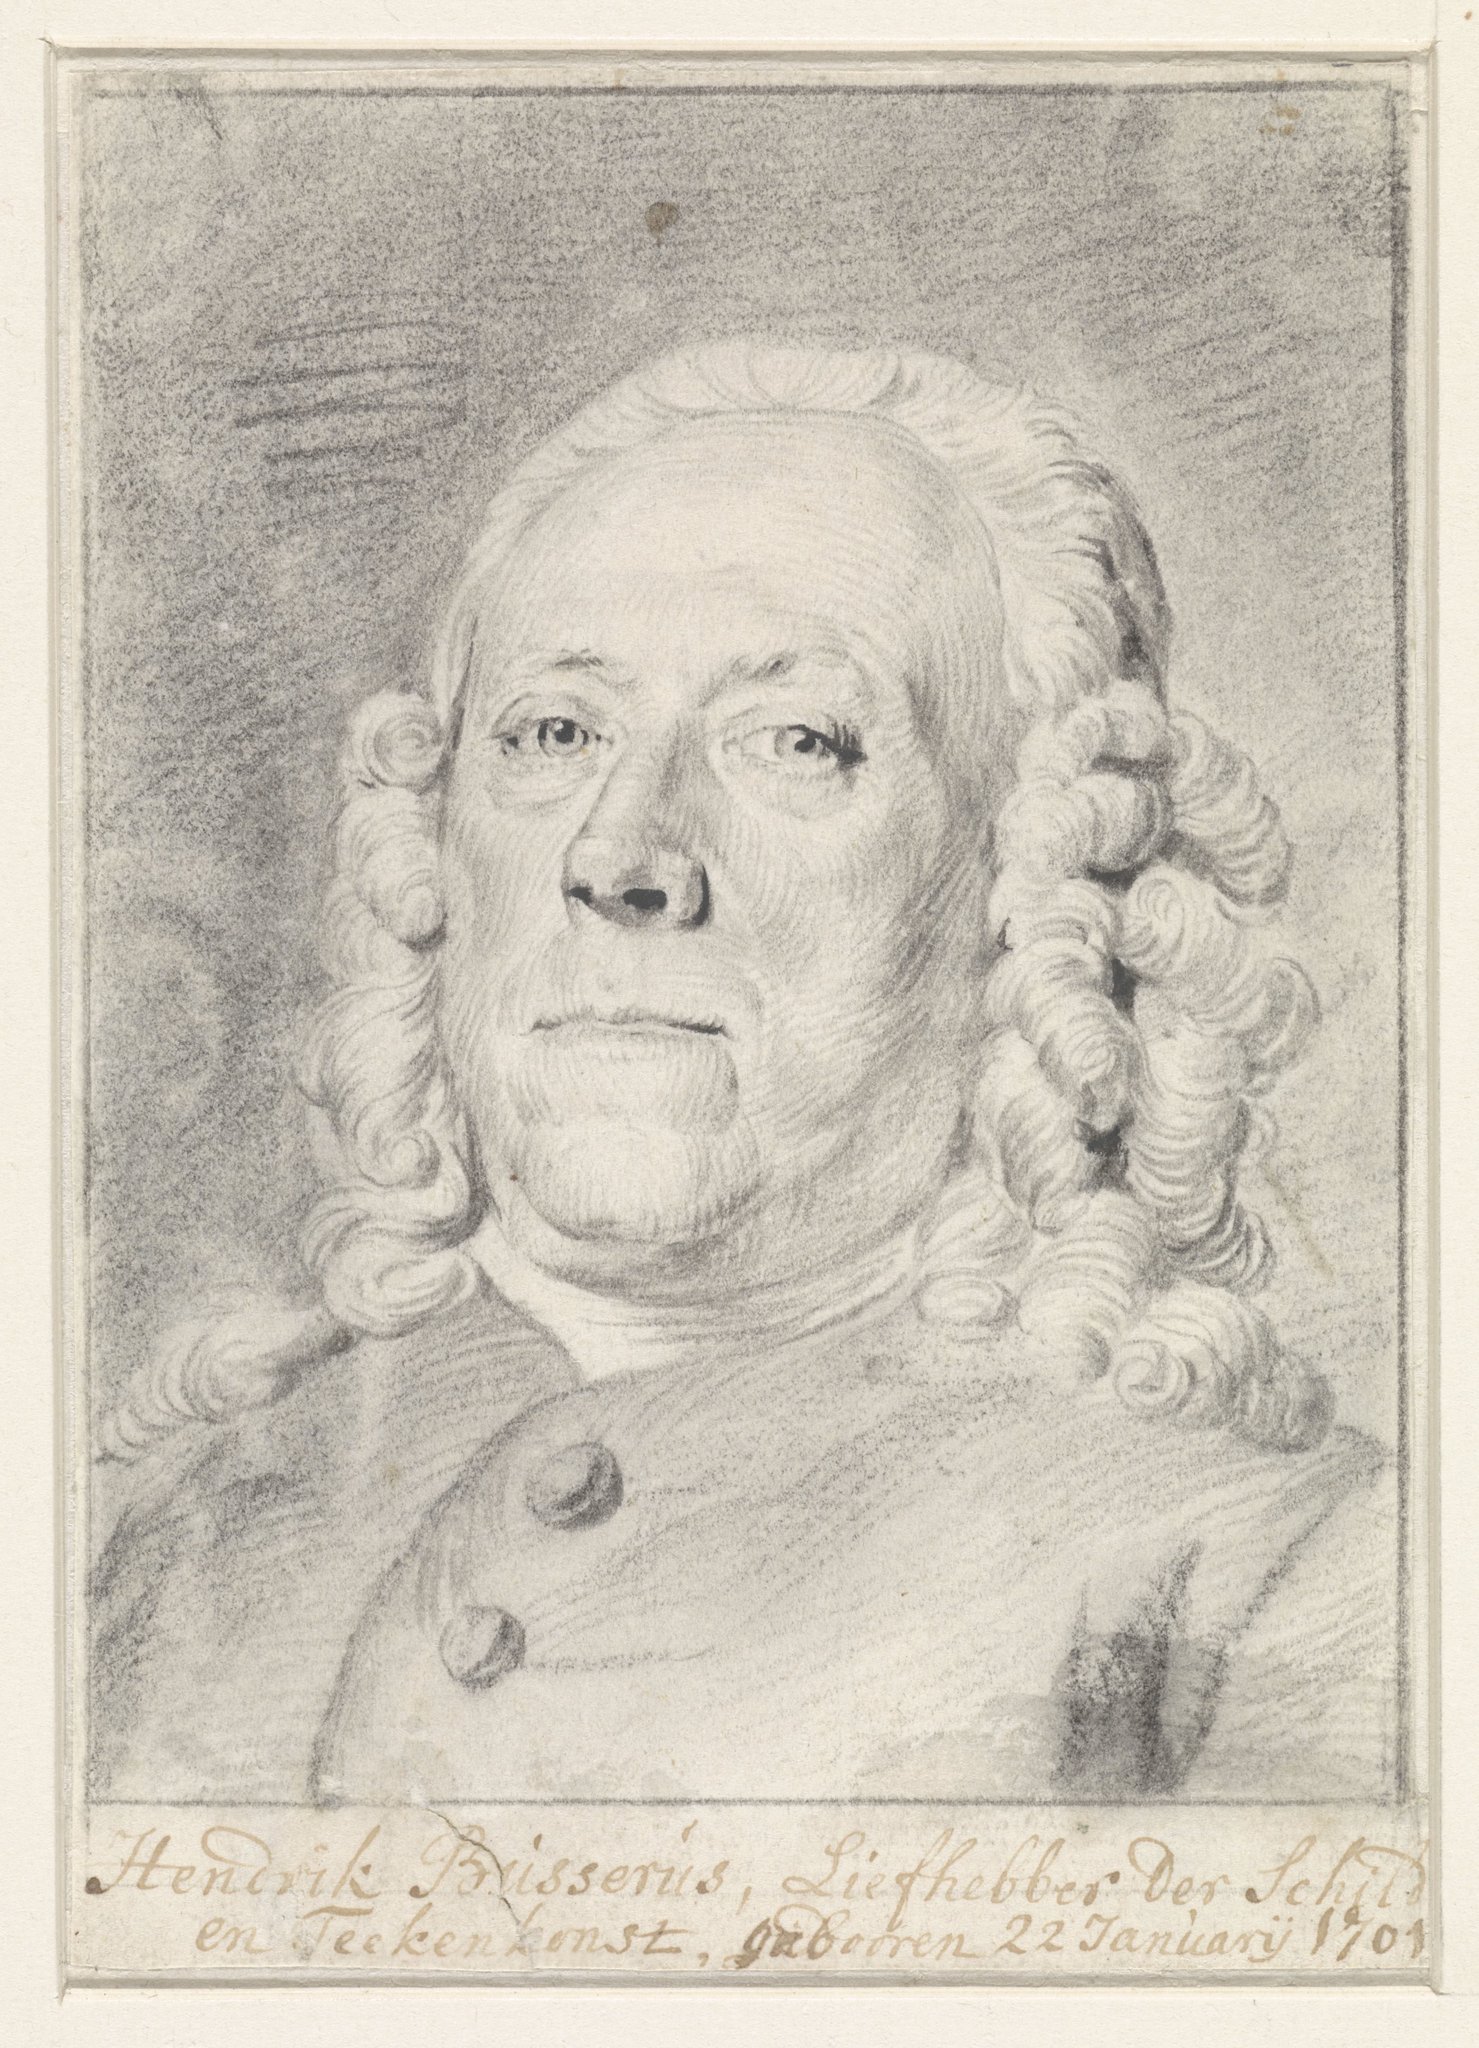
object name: drawing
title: Portret van Hendrik Busserus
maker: hendrik pothoven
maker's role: draughtsman, painter, print maker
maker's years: 1725-1807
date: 1738-1793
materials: chalk, paper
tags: amsterdam, print maker, hendrik busserus, historical persons, portrait, self-portrait of painter, portrait, self-portrait of artist, portrait, self-portrait of draughtsman